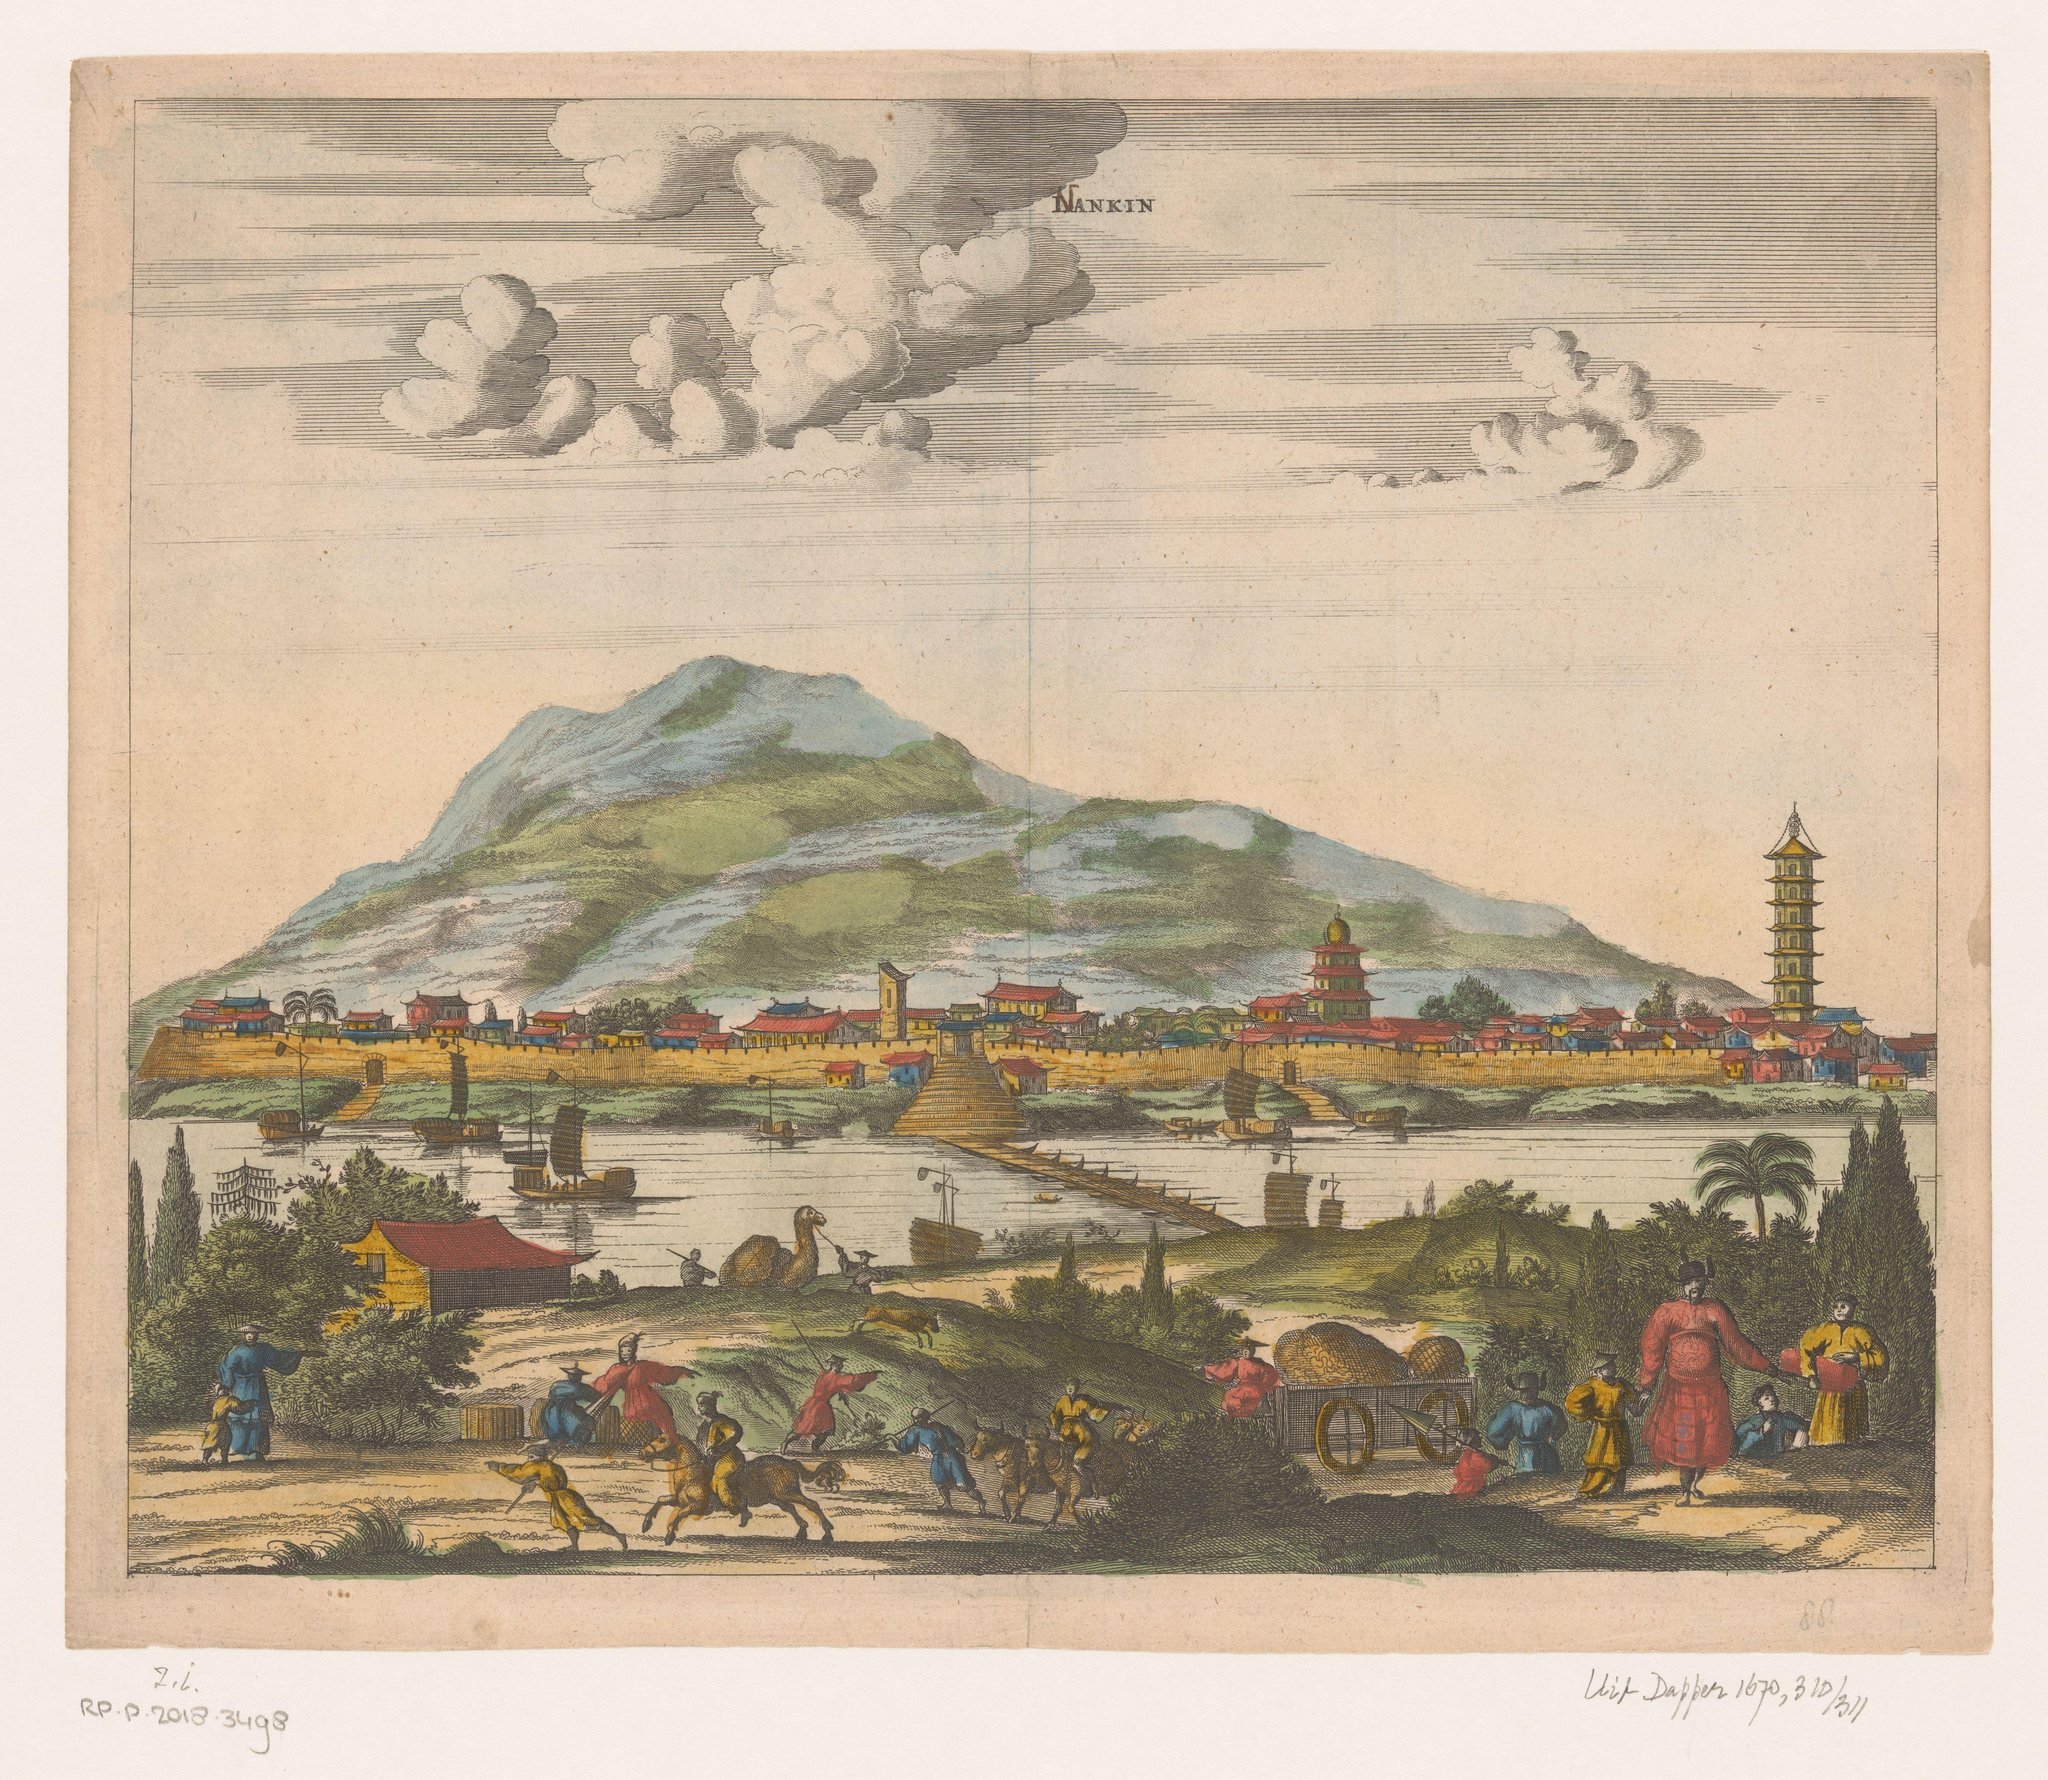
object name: book illustration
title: Gezicht op de Chinese stad Nanjing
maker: Anonymous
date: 1670-1671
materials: paper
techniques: engraving, hand coloring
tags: river, prospect of city, town panorama, silhouette of city, china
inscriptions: collector's mark: Lugt 2228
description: Prent uit: Montanus, Arnoldus. Atlas Chinensis: Being a Second Part of a Relation of Remarkable Passages in two Embassies (...). Londen: Thomas Johnson, 1671, p. 284-285. Of: Dapper, Olfert. Gedenkwaerdig bedryf der Nederlandsche Oost-Indische maetschappye, op de kuste en in het keizerrijk van Taising of Sina (...). Amsterdam: Jacob van Meurs, 1670, p. 308-309.